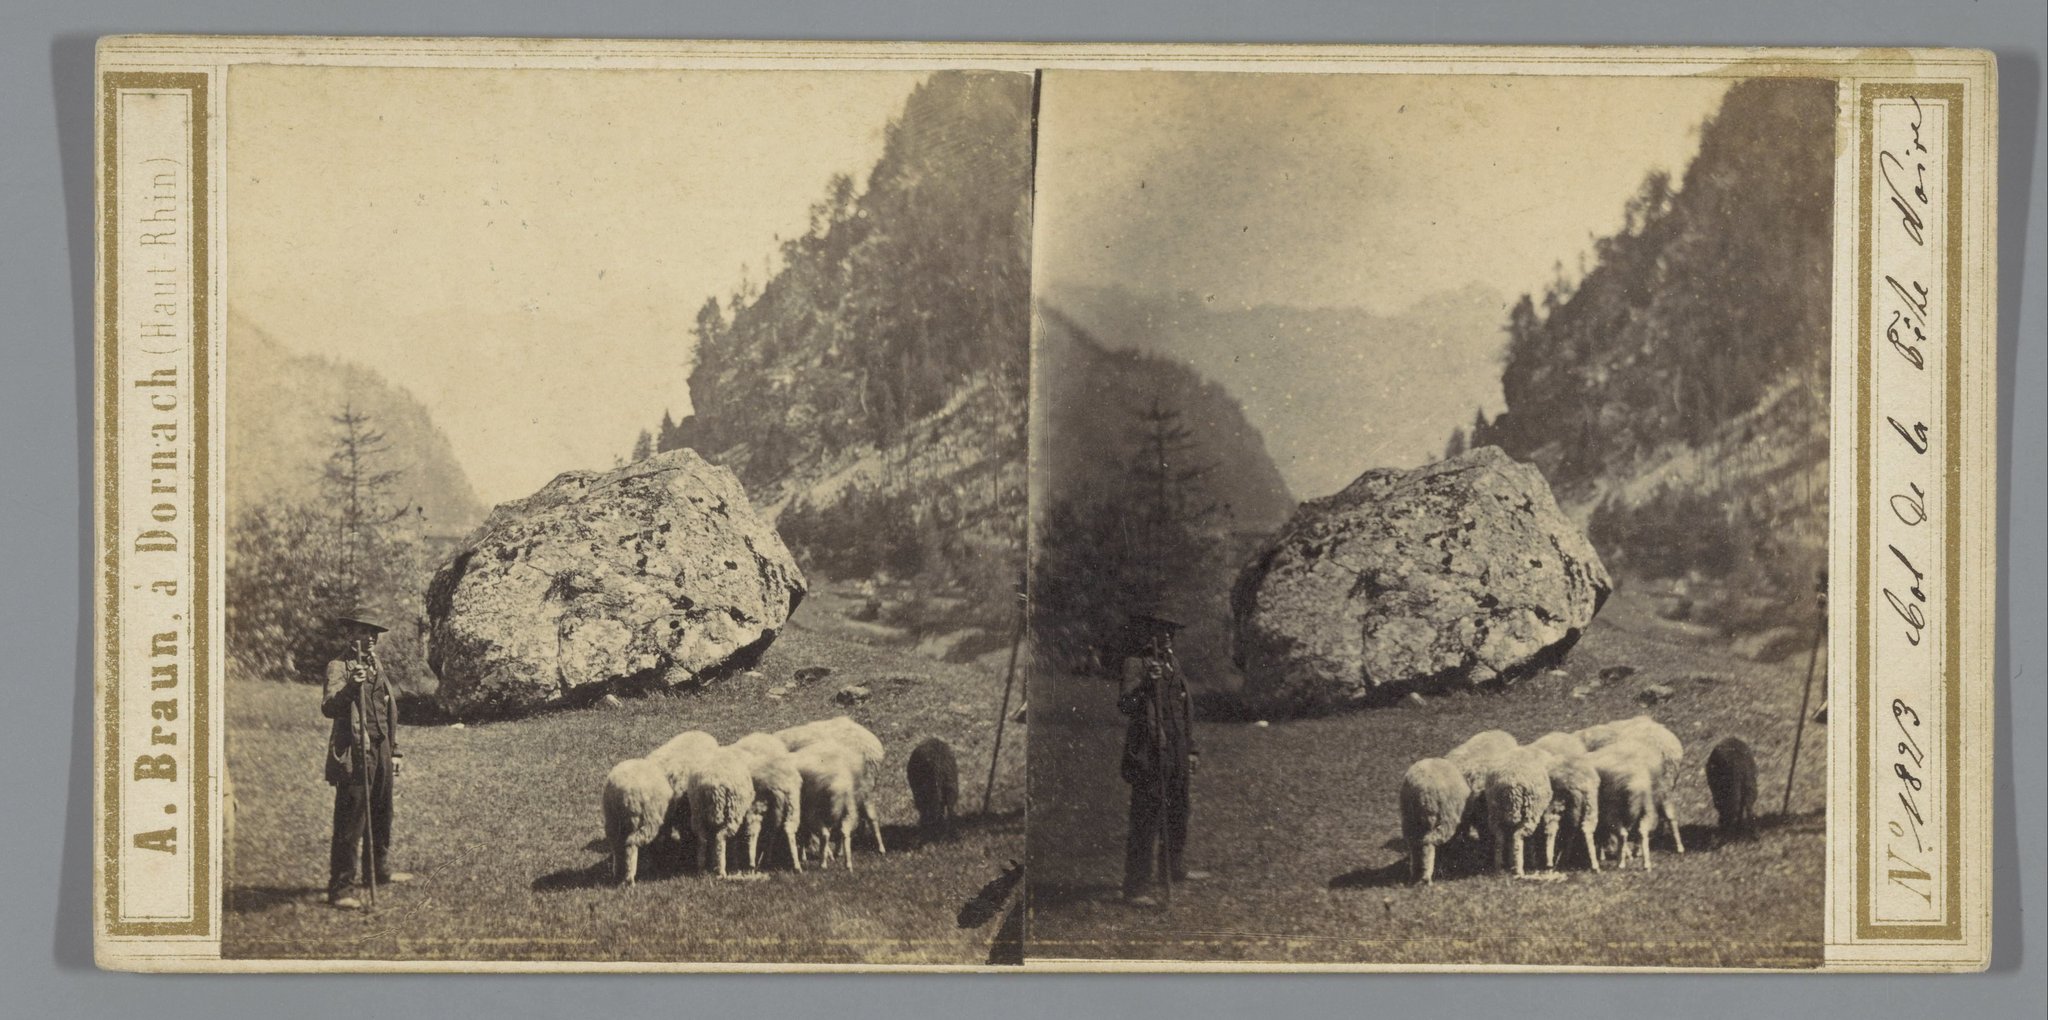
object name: stereograph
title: Col de la Tête Noire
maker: Anonymous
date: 1860-1866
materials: cardboard, paper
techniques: albumen print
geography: corno nero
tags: herding, herdsman, herdswoman, shepherd, shepherdess, cowherd, etc.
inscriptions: number: ‘No. 1823’